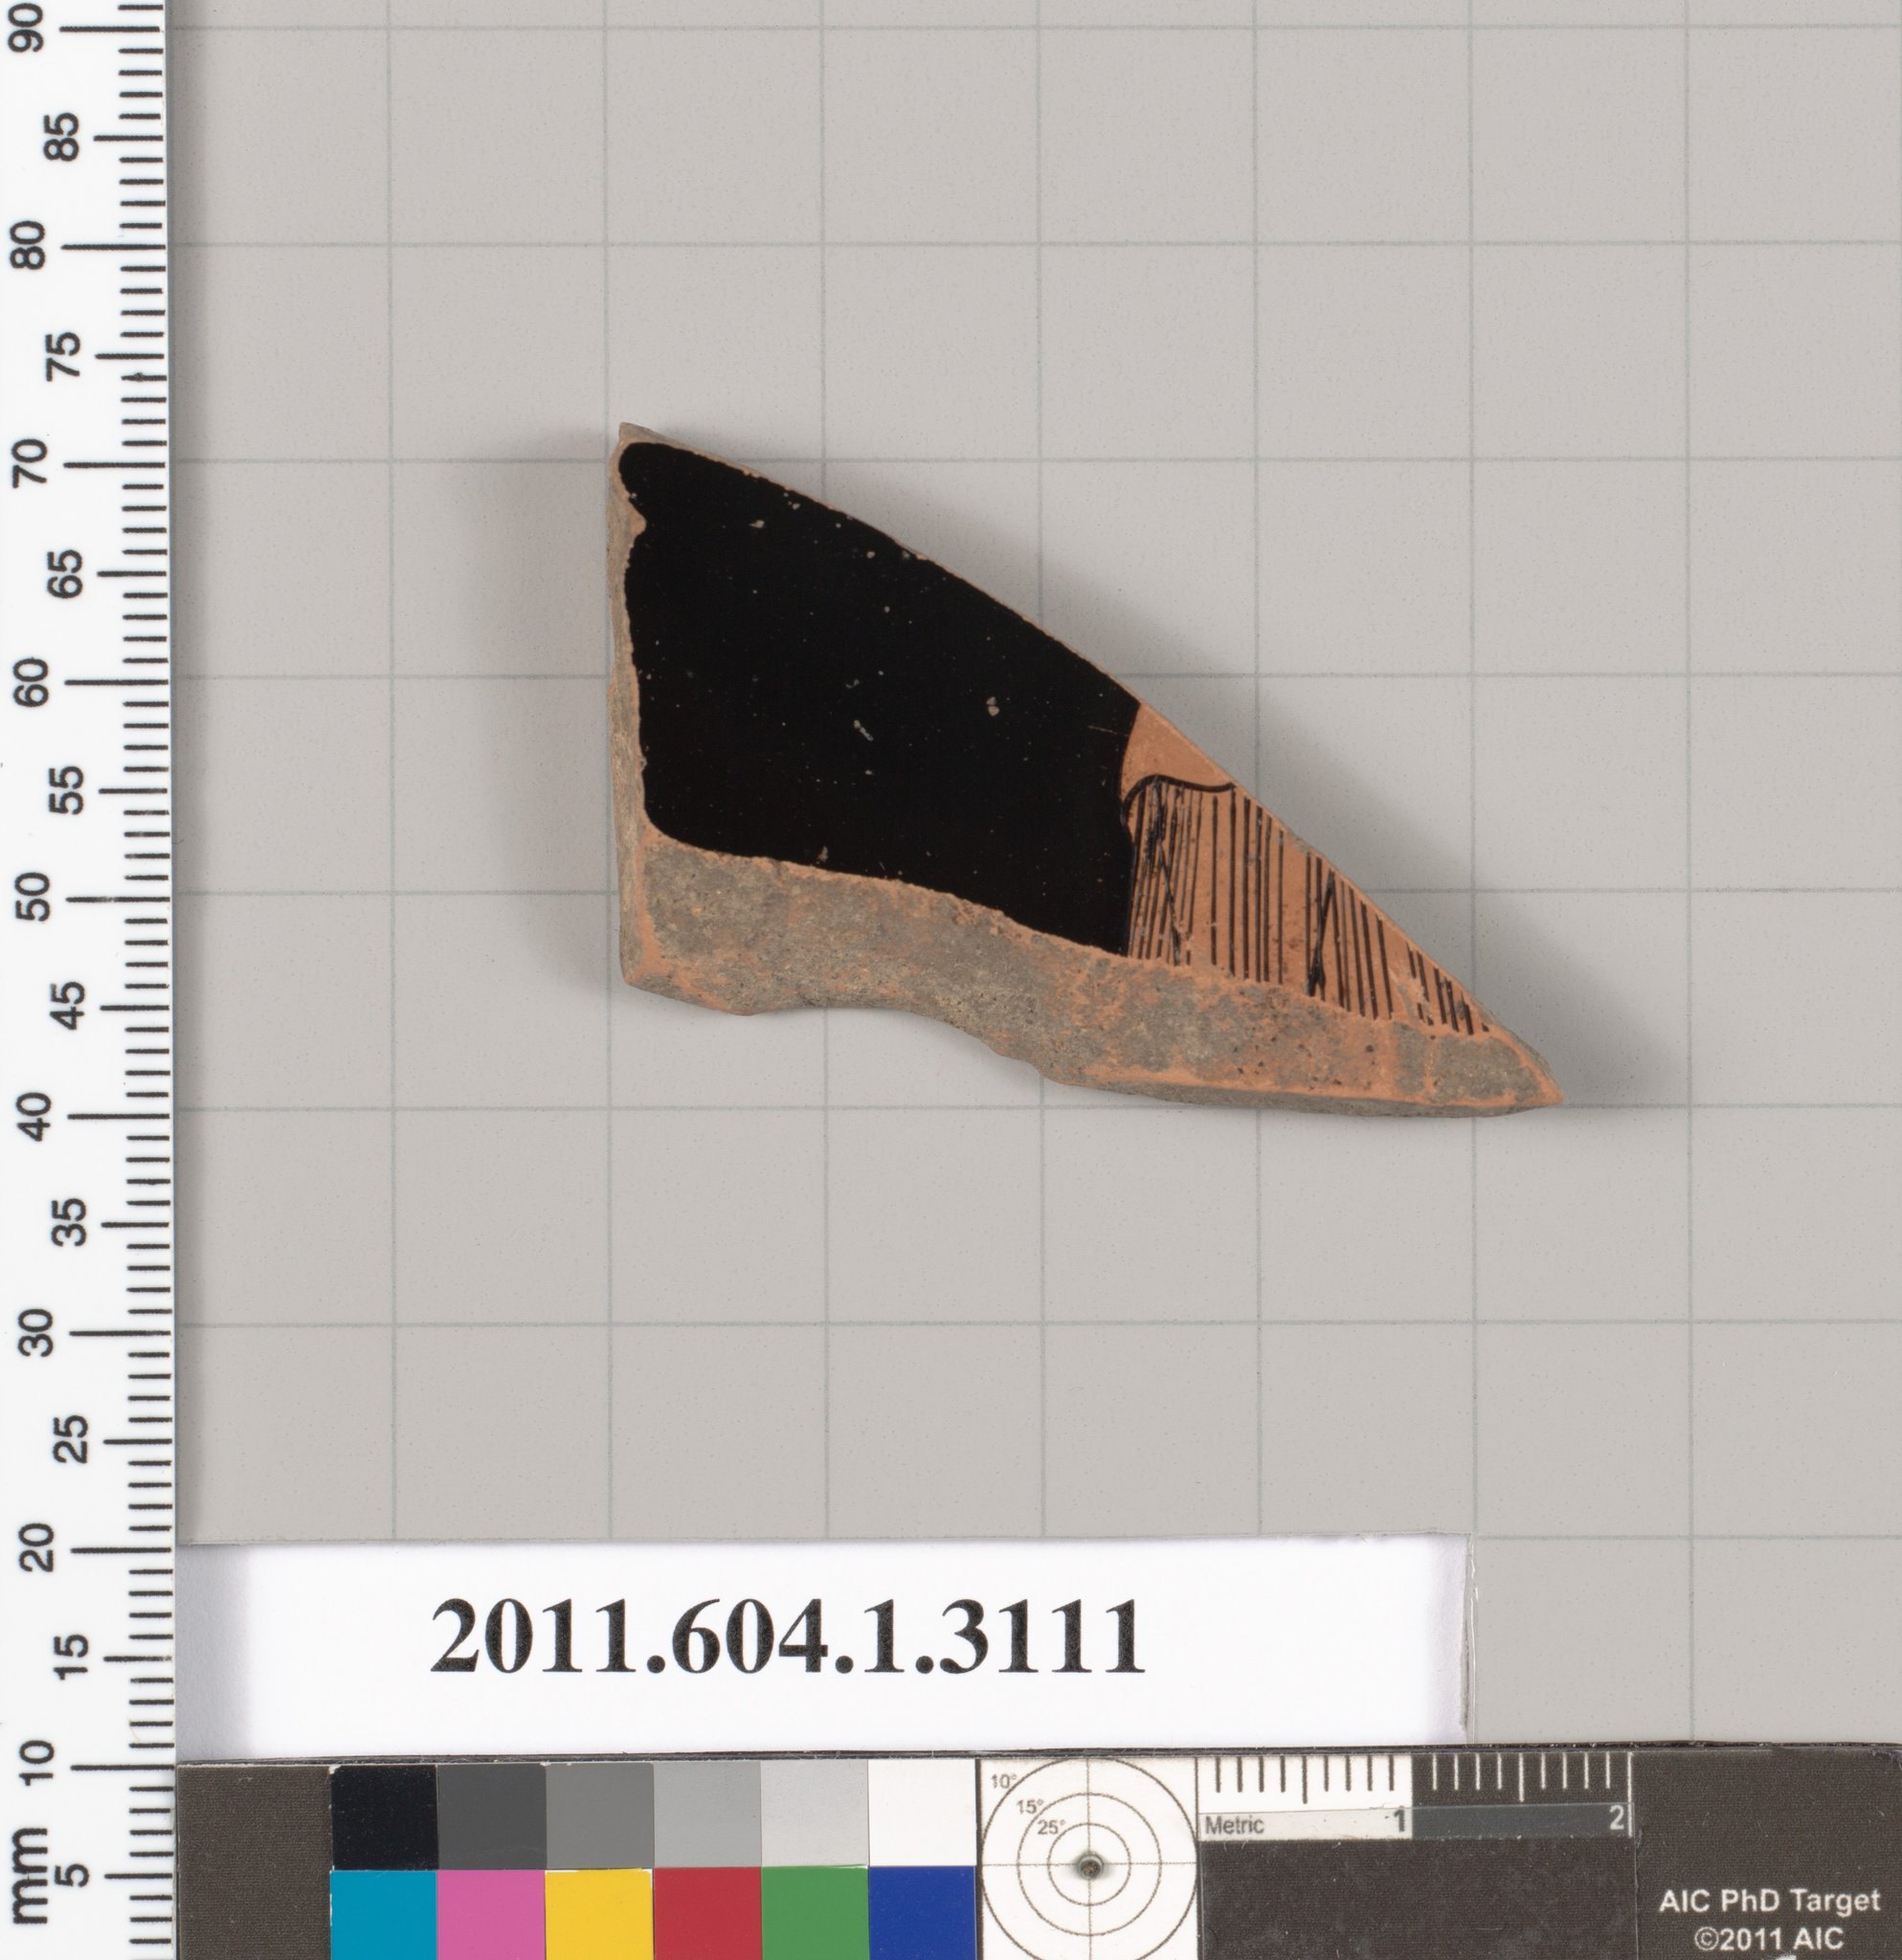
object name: kylix fragment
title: Terracotta fragment of a kylix (drinking cup)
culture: greek, attic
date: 490-480 BCE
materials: terracotta